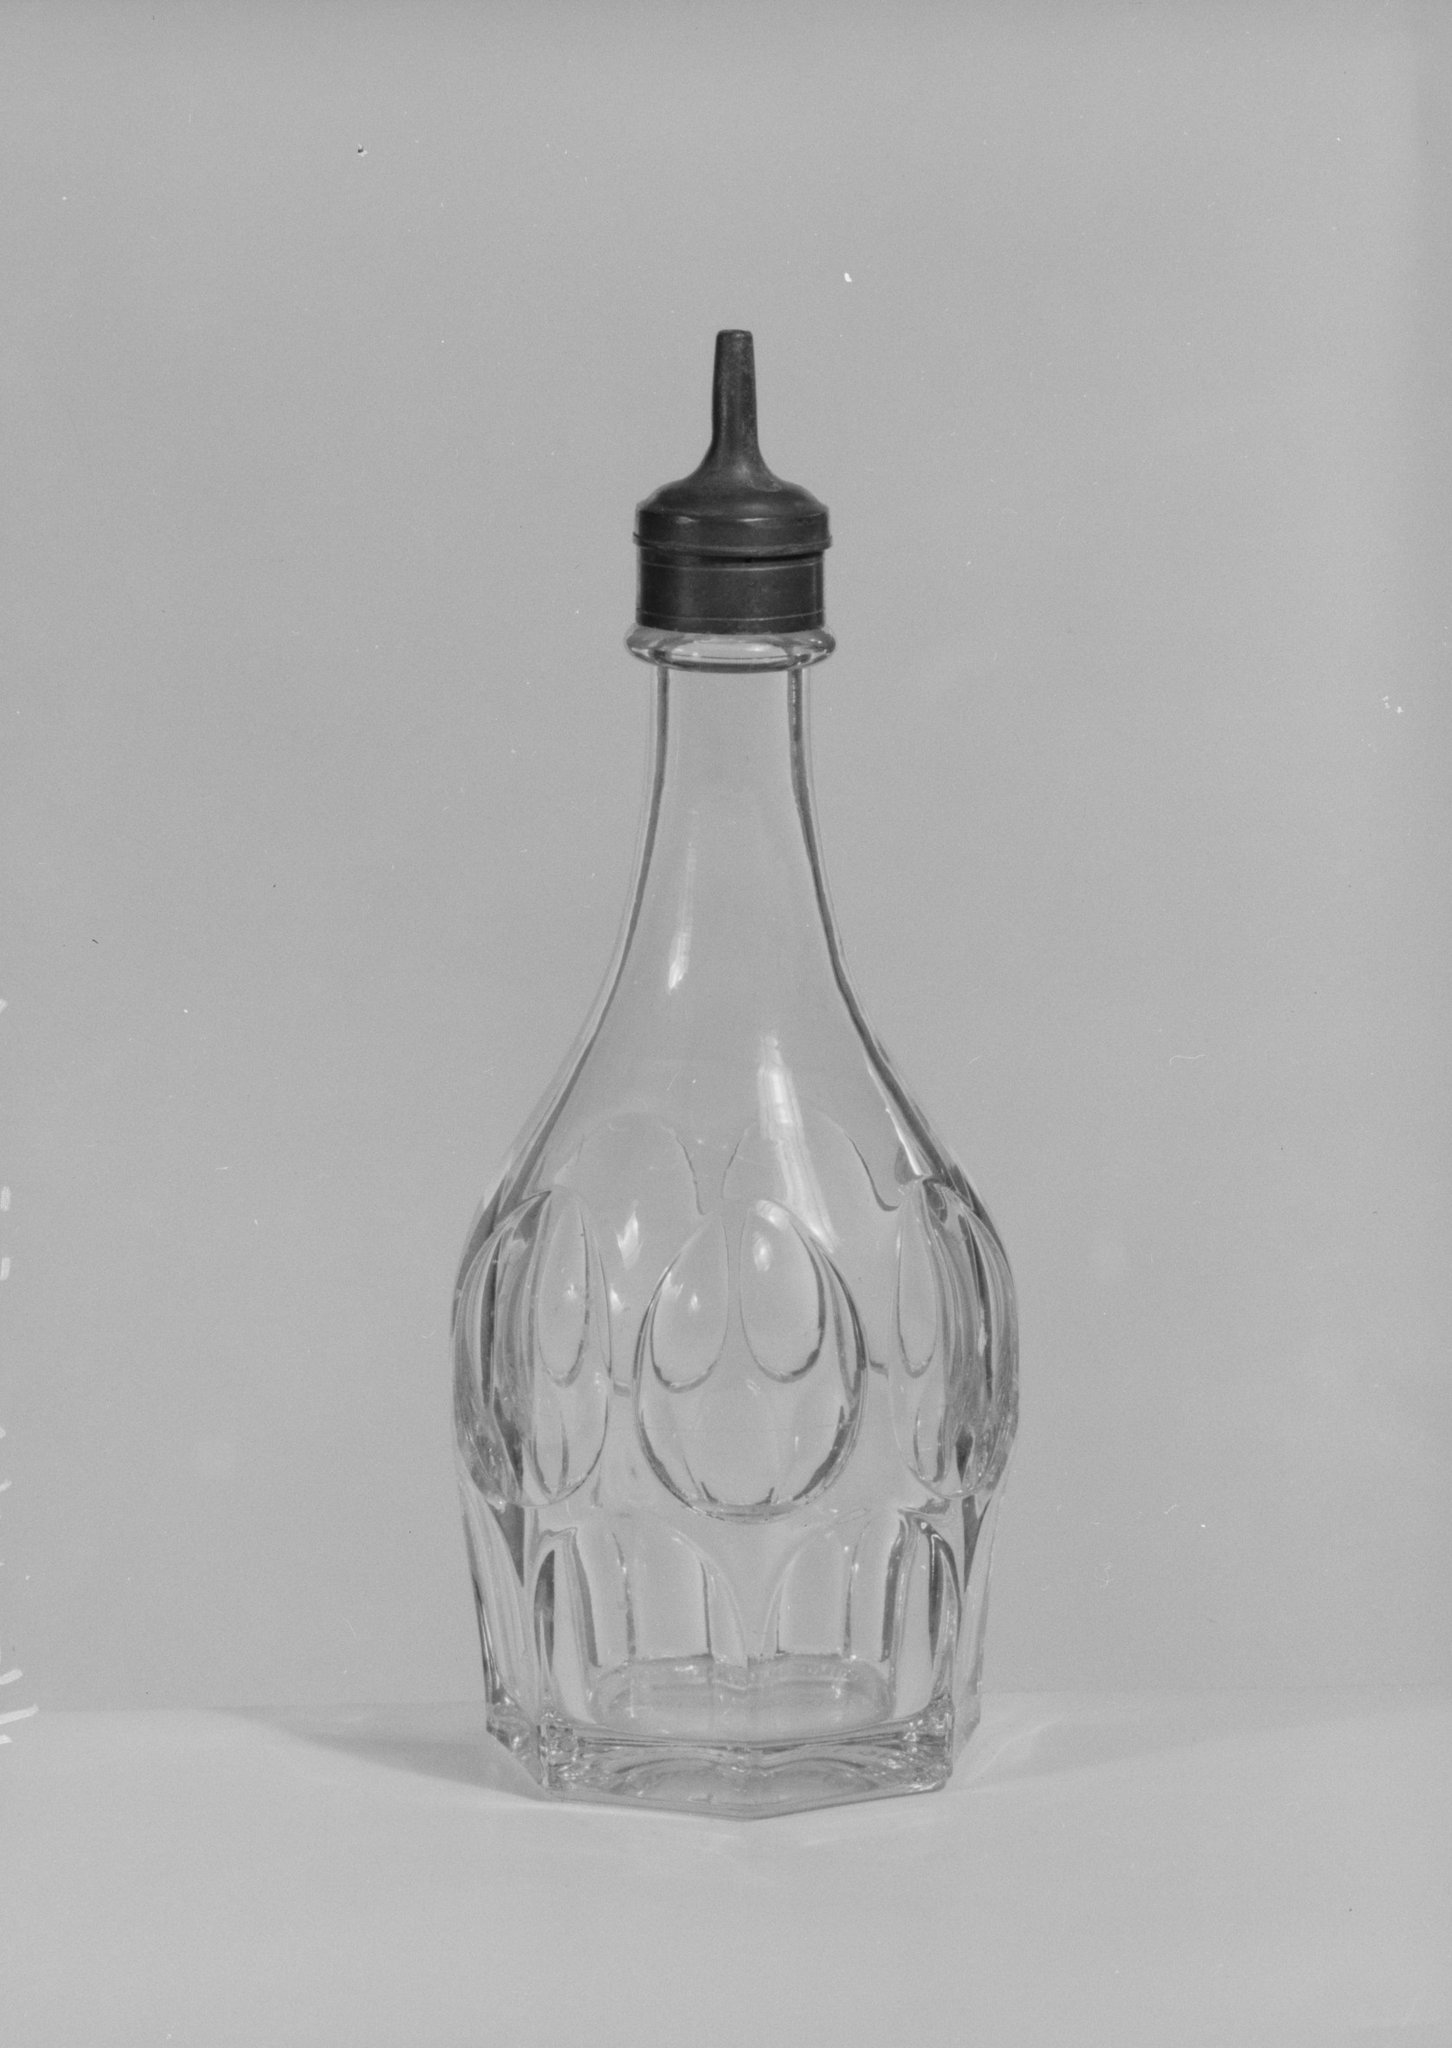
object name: pepper sauce bottle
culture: american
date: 1860-1870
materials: glass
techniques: pressed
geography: united states